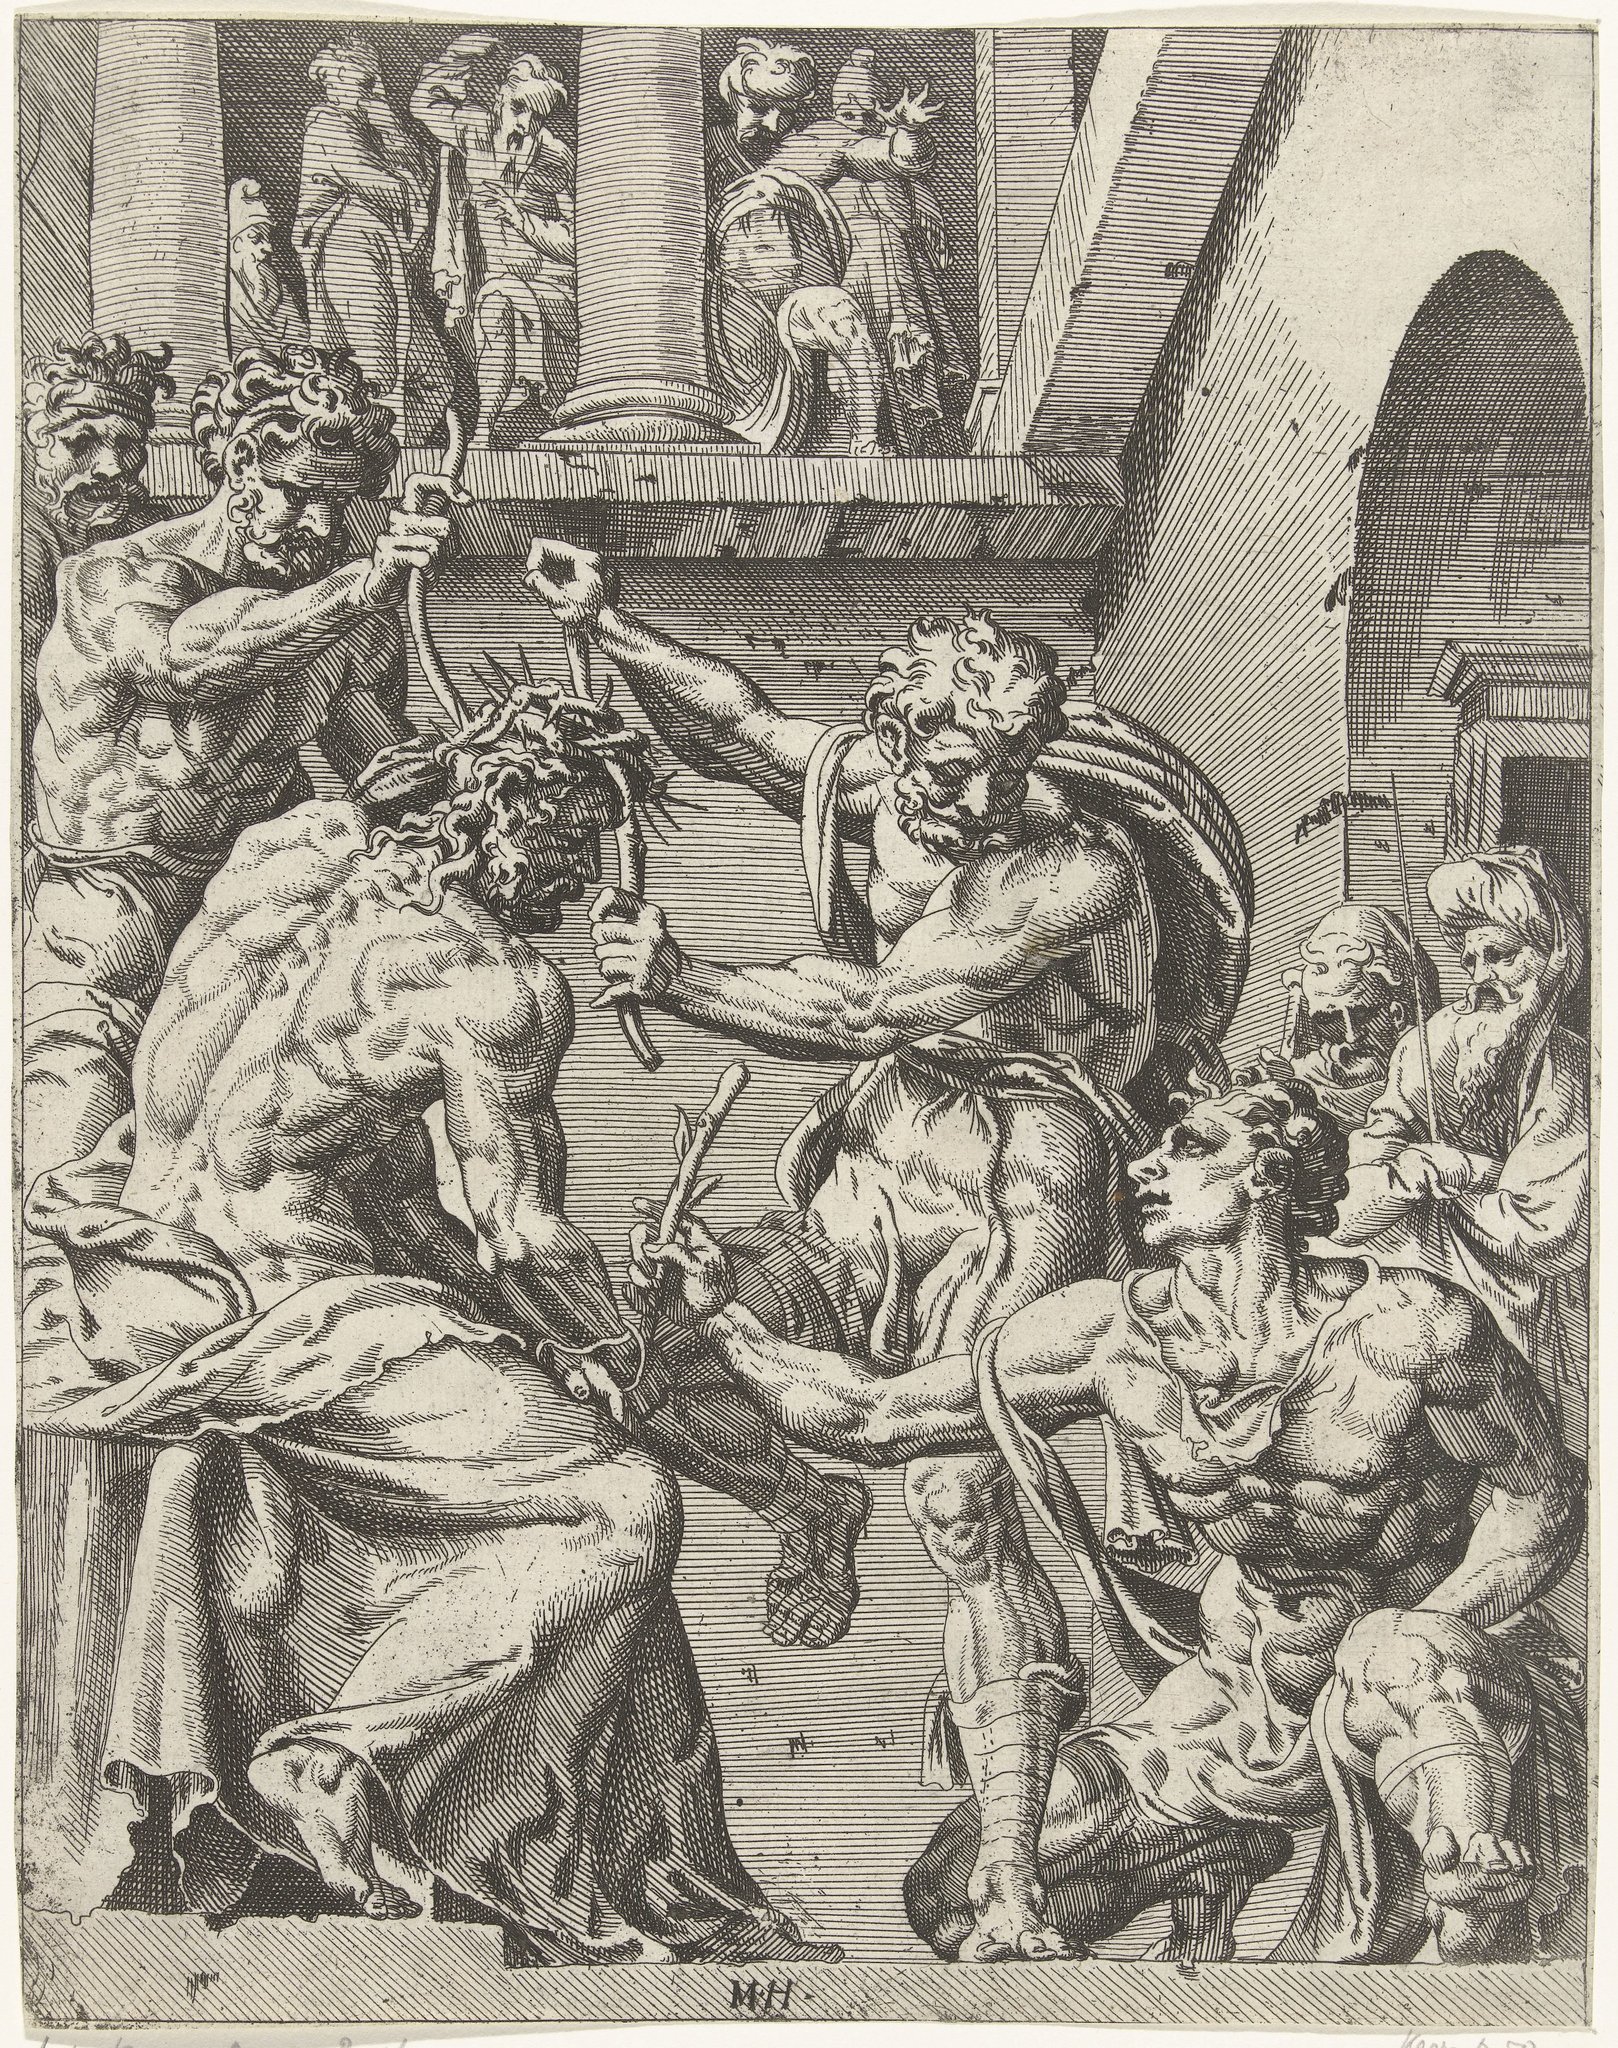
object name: print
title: Christus wordt gekroond met de doornenkroon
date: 1548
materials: paper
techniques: etching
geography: haarlem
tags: the crowning with thorns: soldiers with sticks place a thorny crown on christ's head and give him a reed (matthew 27:27-31; mark 15:16-20; john 19:2-3)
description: Christus wordt door de soldaten bespot. Hij krijgt een doornenkroon op zijn hoofd en een grasspriet als scepter. De prent is deel van een dertigdelige serie met prenten over de zondeval en Christus' passie.